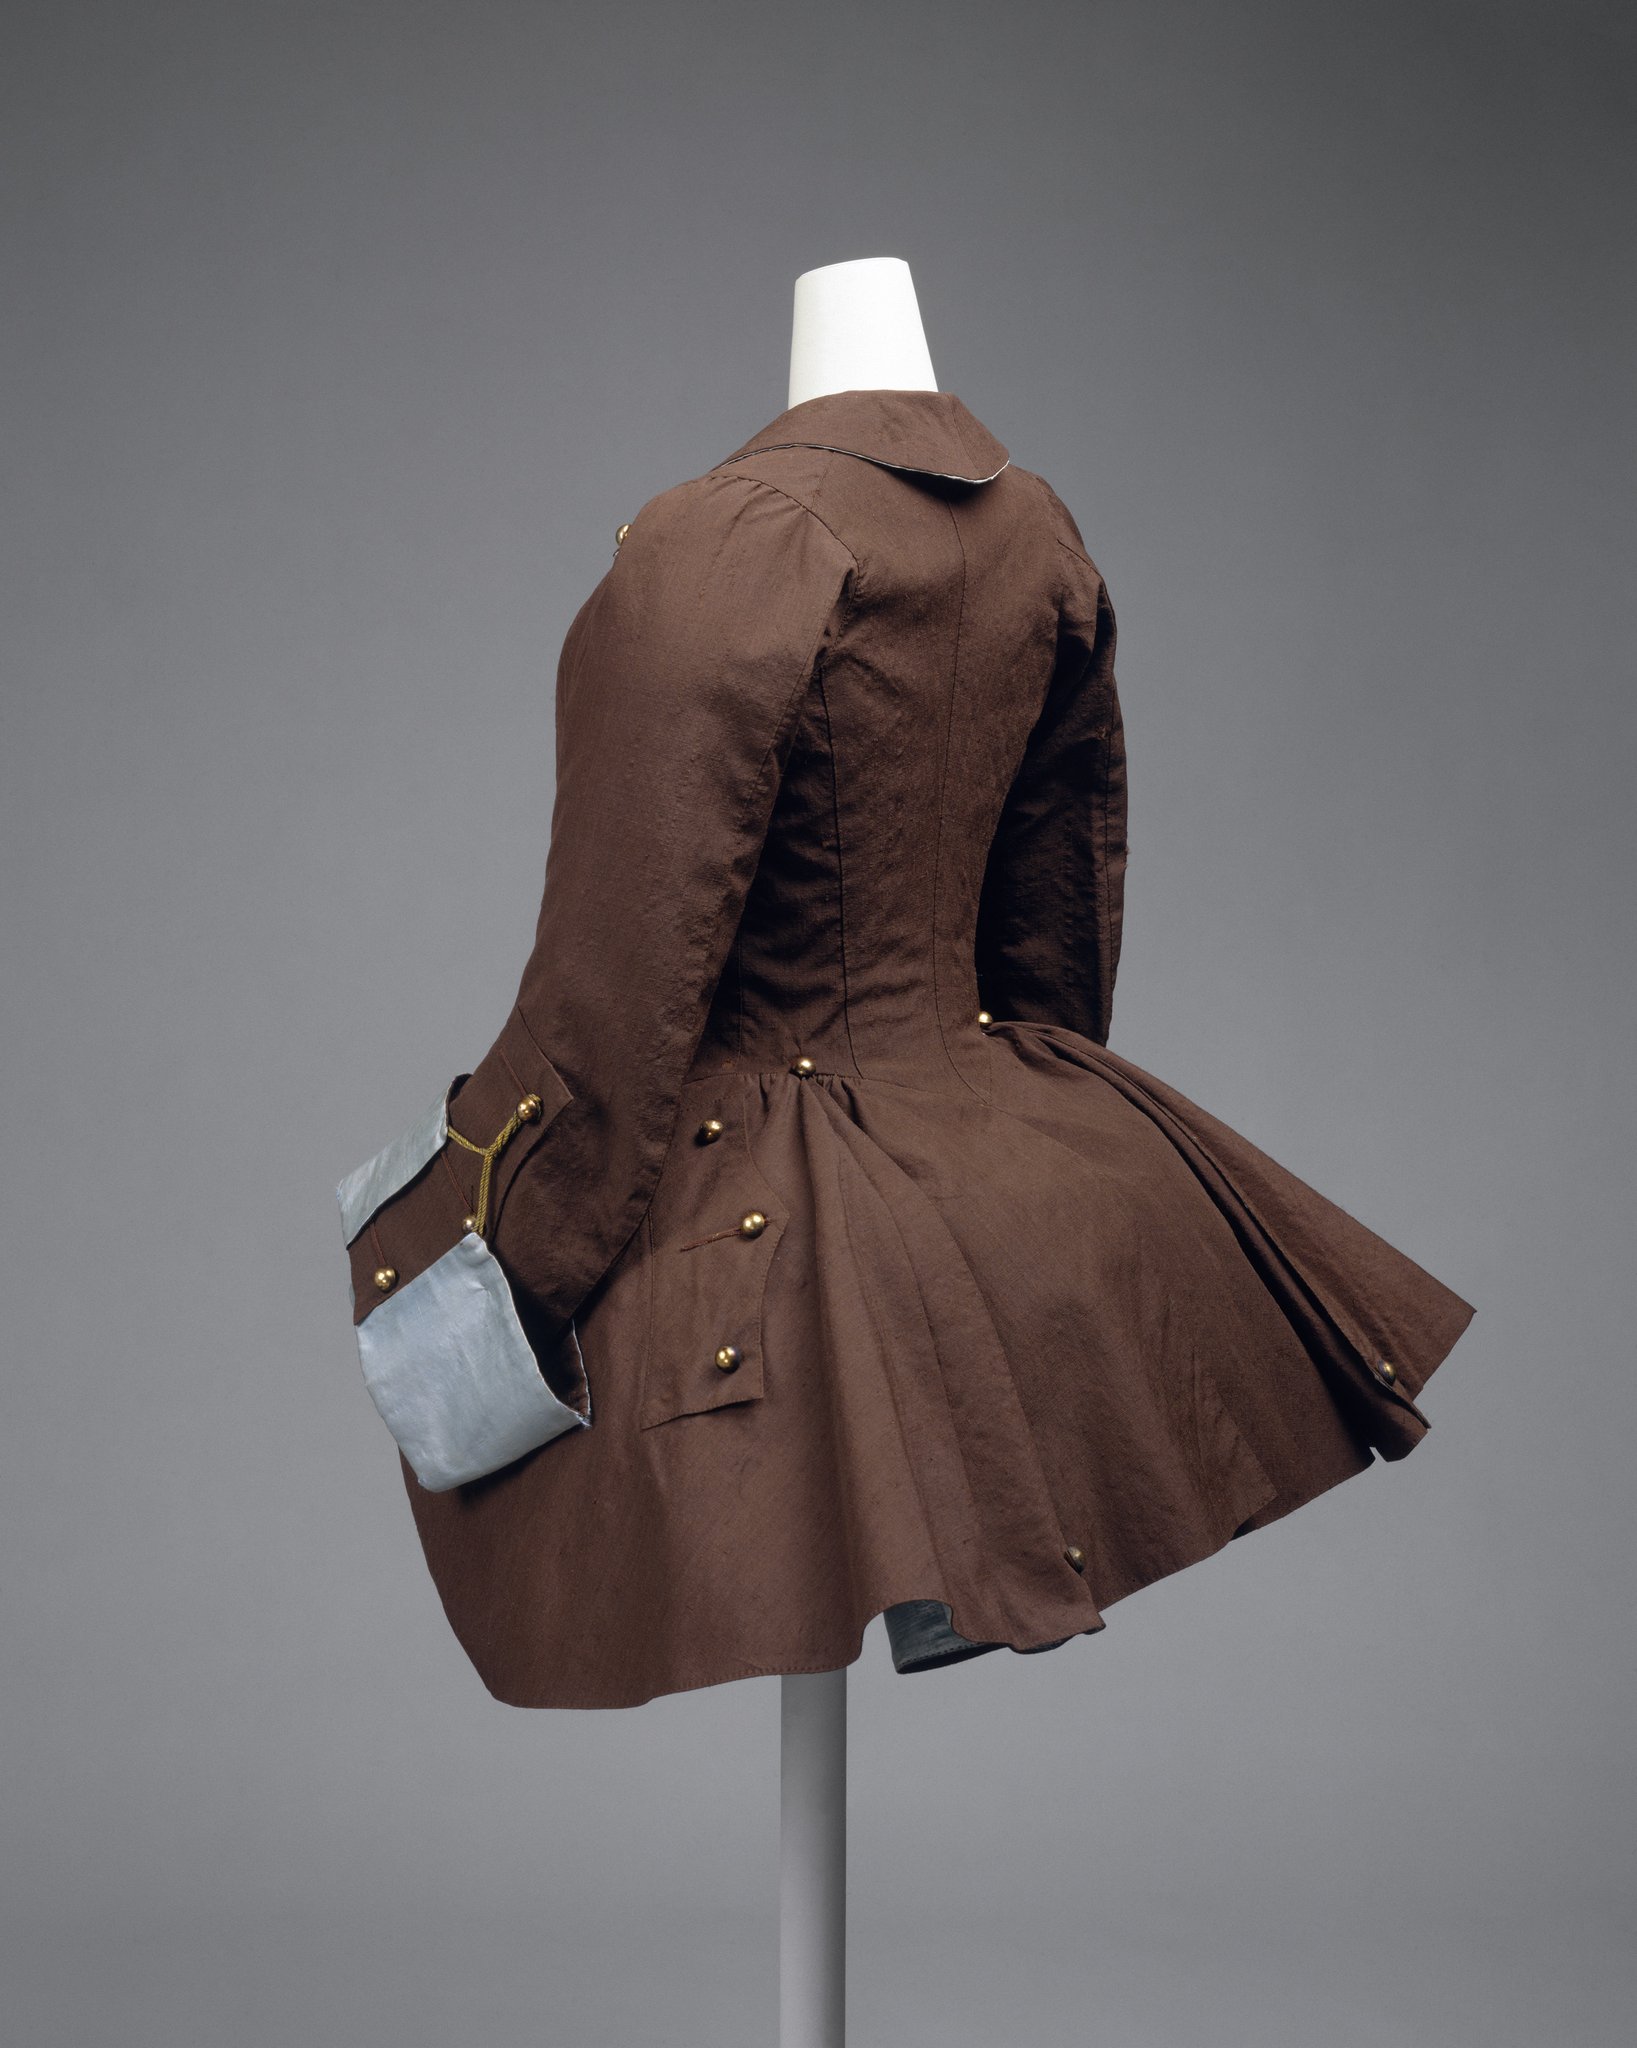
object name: riding coat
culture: british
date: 1760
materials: hair, silk